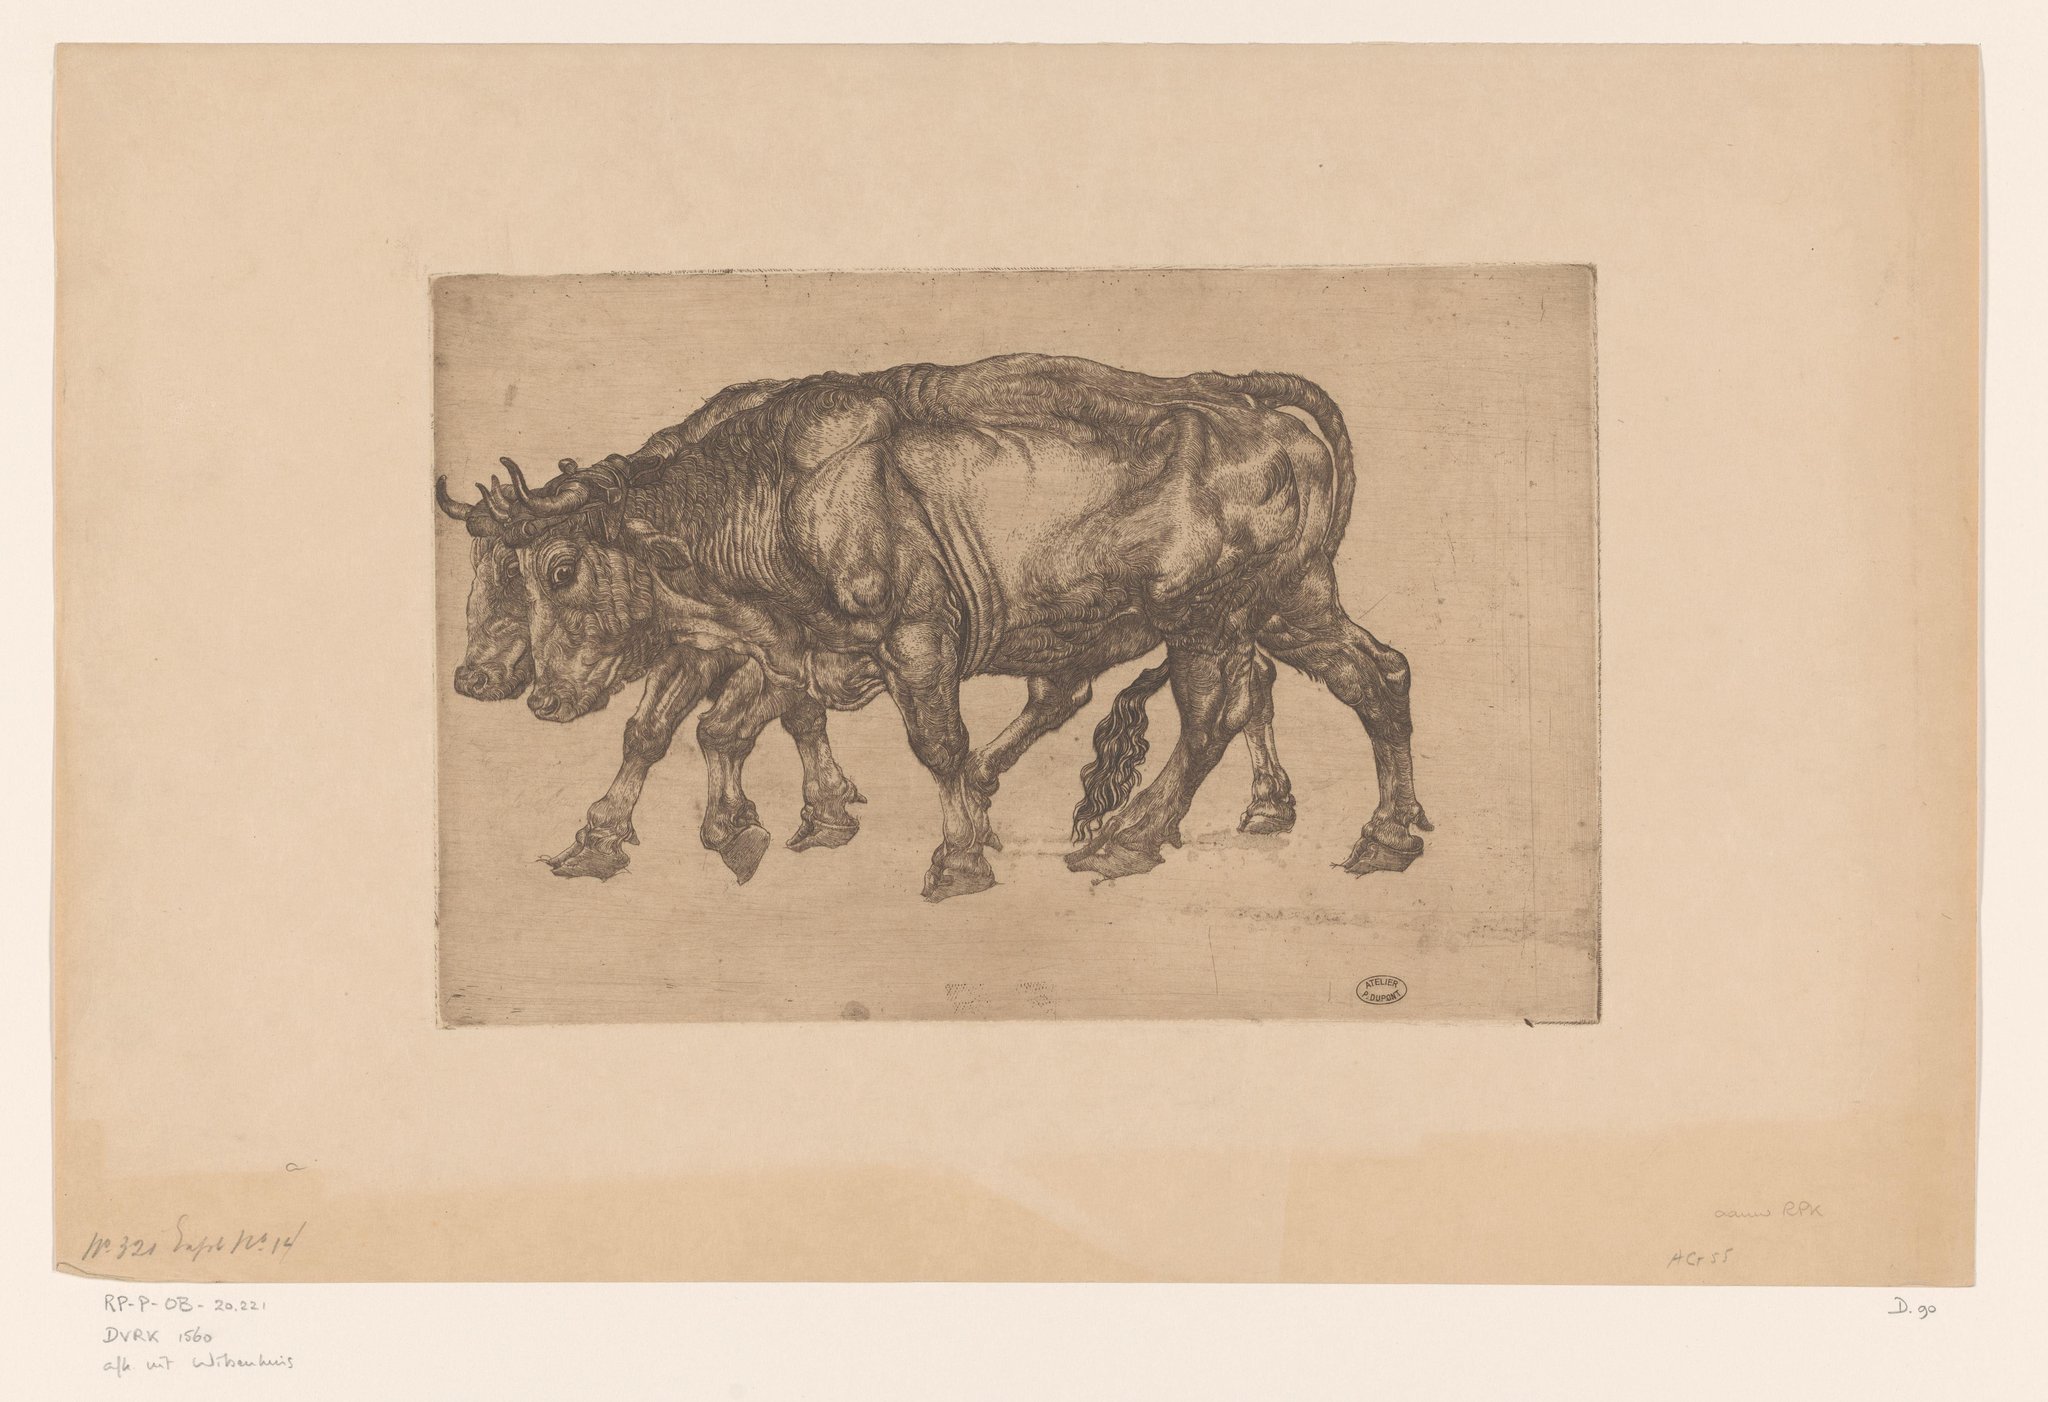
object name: print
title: Twee ossen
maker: pieter dupont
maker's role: draughtsman, print maker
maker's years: 1870-1911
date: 1901-1902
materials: paper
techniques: etching, intaglio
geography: paris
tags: ox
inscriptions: collector's mark: Lugt 705a, inscription: ‘No. 321 [...] No. 14’